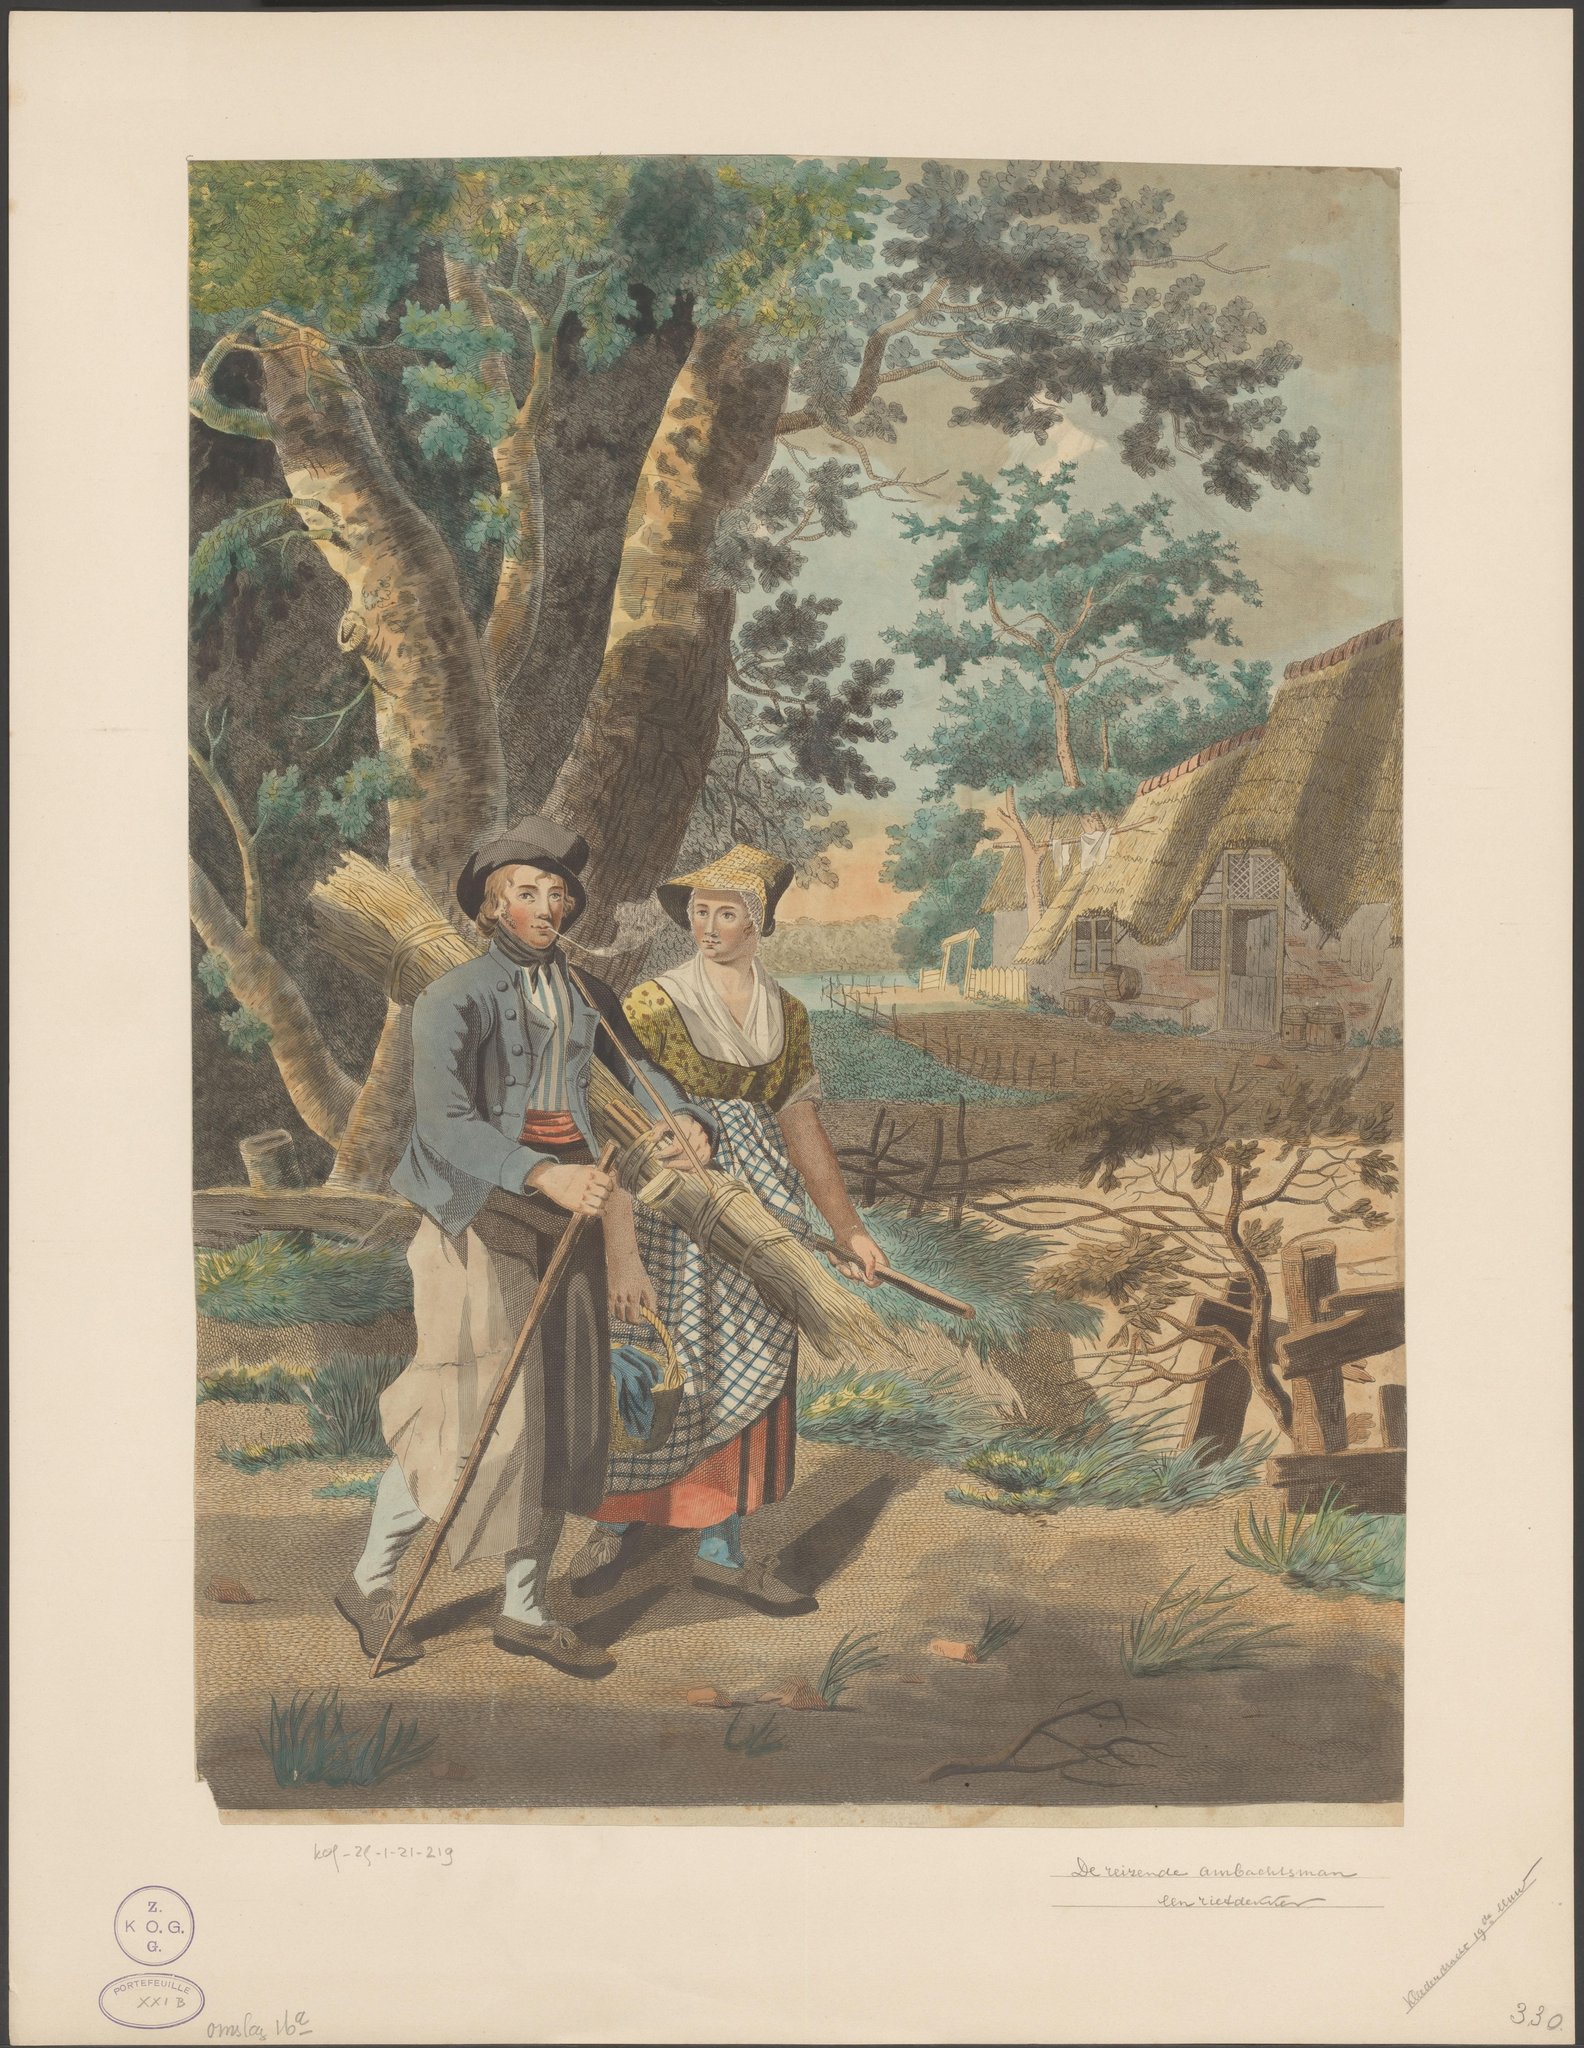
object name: print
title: Ambachtsman reist met een vrouw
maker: Anonymous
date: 1800-1849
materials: paper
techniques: etching, hand coloring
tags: handicrafts, craftsman at work, 'en route', traveller under way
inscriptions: collector's mark: Lugt 1641, stamp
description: De ambachtsman draagt een bos biezen aan een touw over zijn schouder. Volgens de Atlas van Stolk is de man is waarschijnlijk een stoelenmatter, maar hij kan ook een rietdekker zijn. Onderwerpsrubrieken binnen de Atlas Zeden en Gewoonten: Zeden en Gewoonten in Engeren Zin, De Kleeding, Kleederdrachten (tijdvakken), Het begin der 19de eeuw. Mannen en vrouwen.